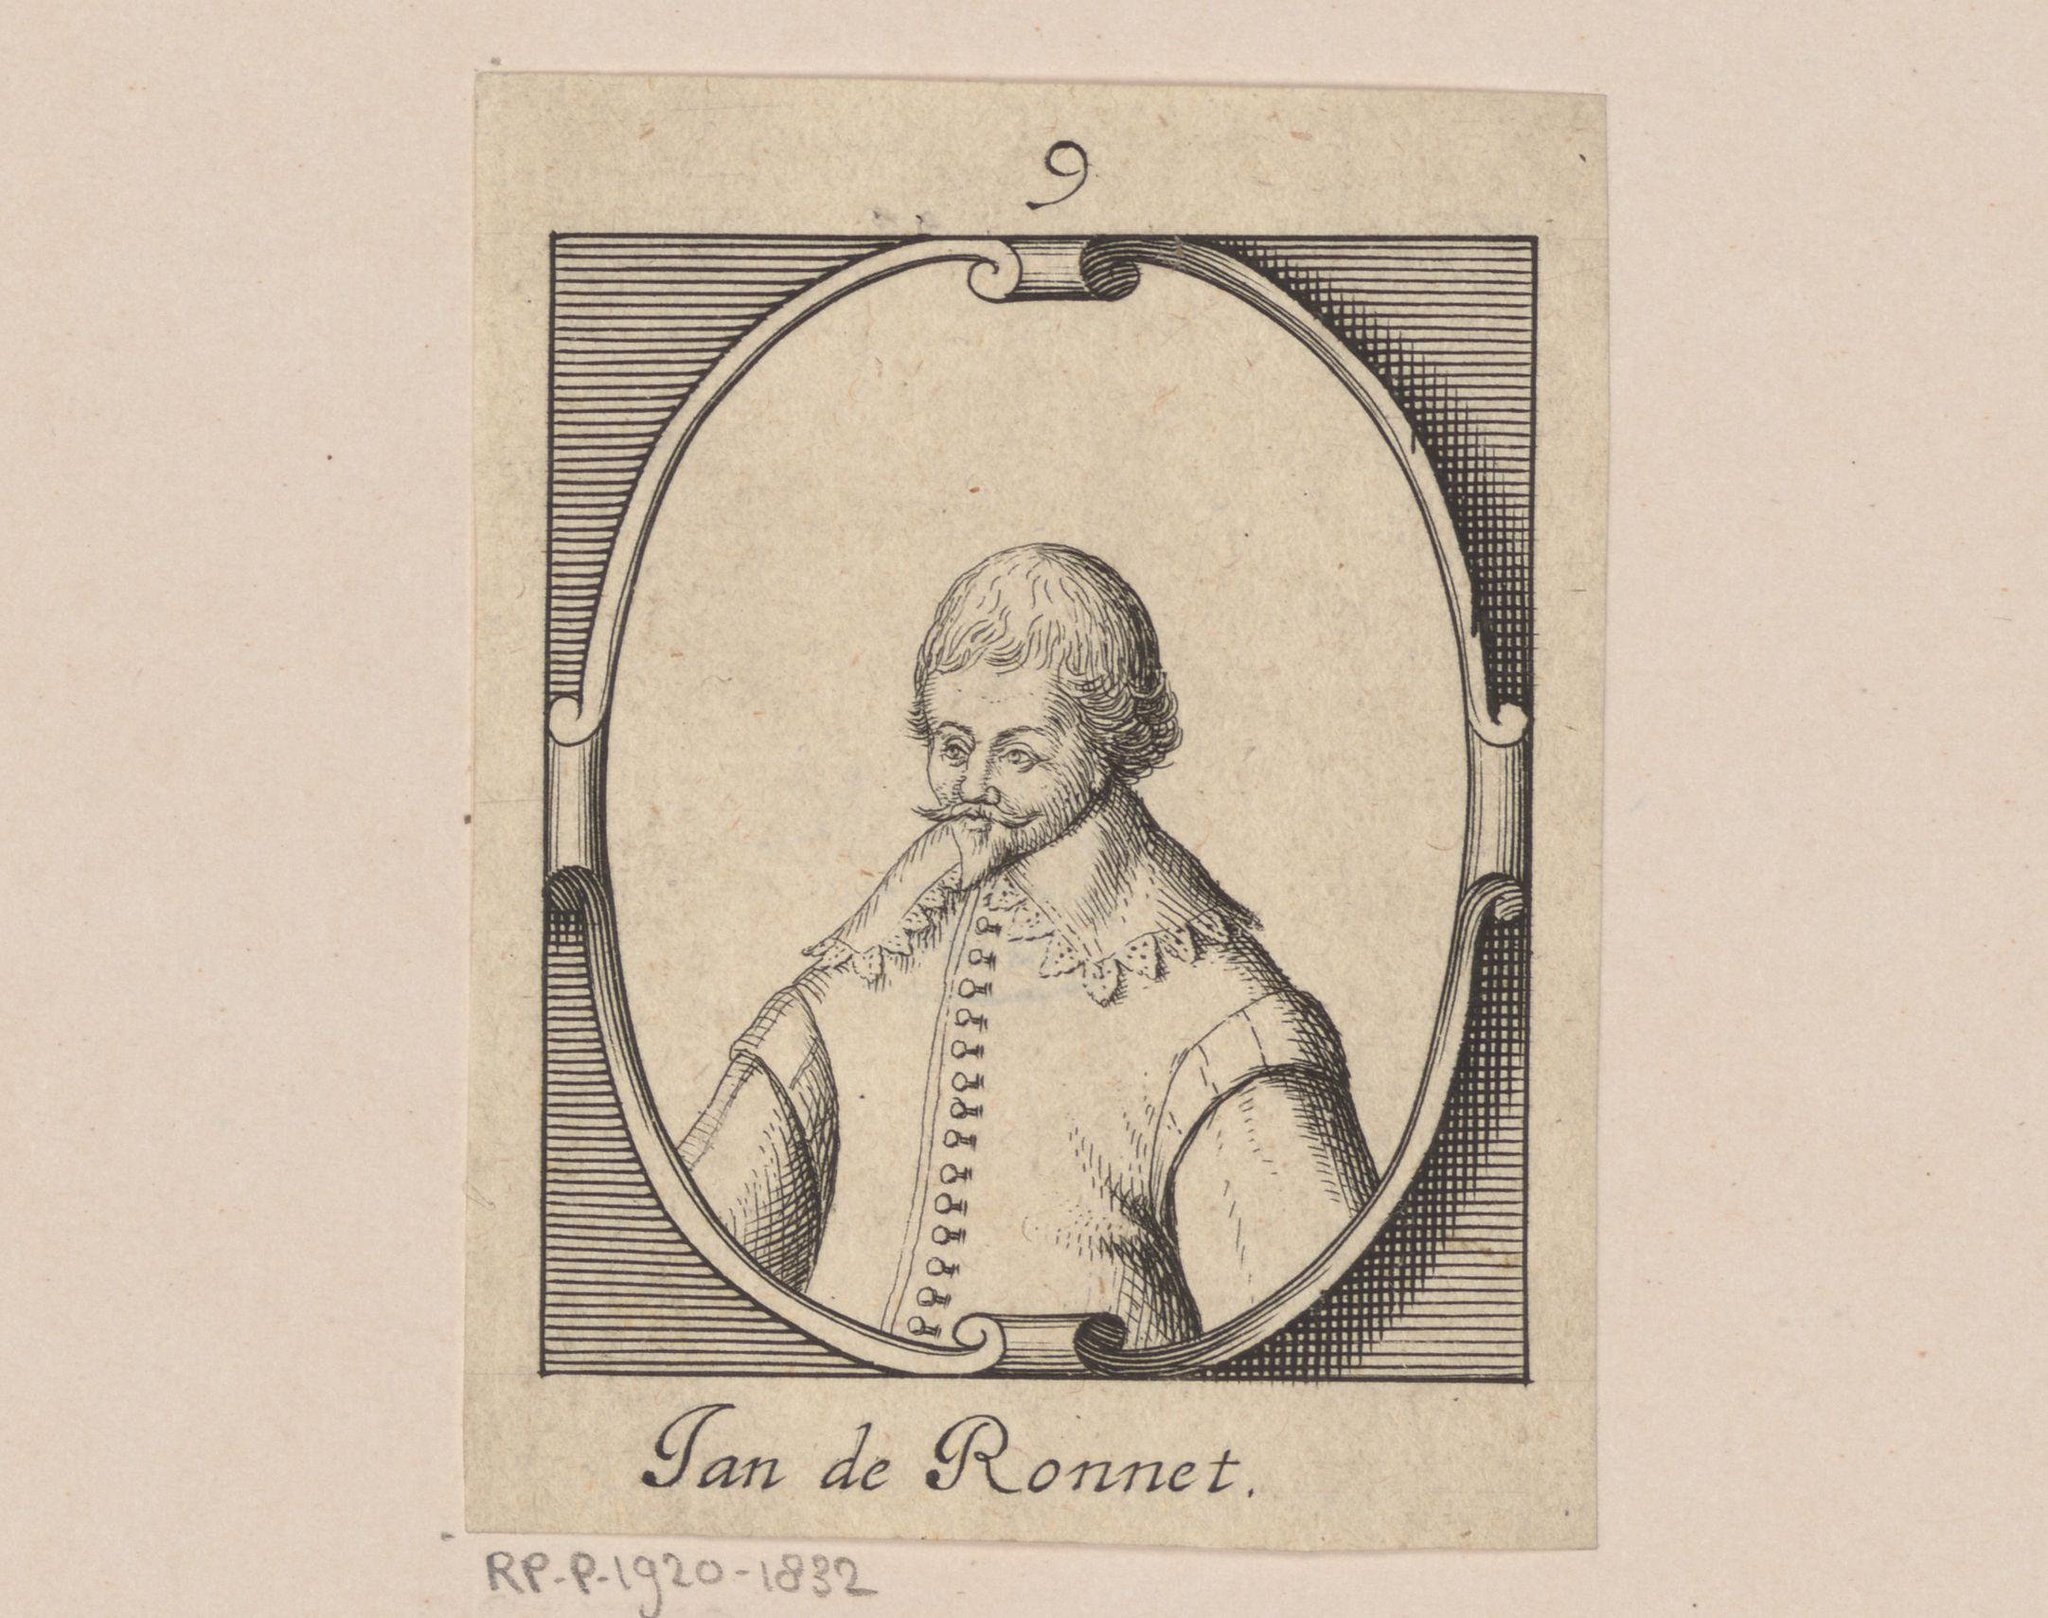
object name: print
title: Portret van Joannes de Romiet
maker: Anonymous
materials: paper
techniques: engraving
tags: historical persons, the hague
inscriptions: collector's mark: Lugt 2228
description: Prent geknipt uit een grotere prent, zie RP-P-OB-81.356. Tien Brabantse afgevaardigden bij de vredesbesprekingen in Den Haag, 4-14 december 1632.